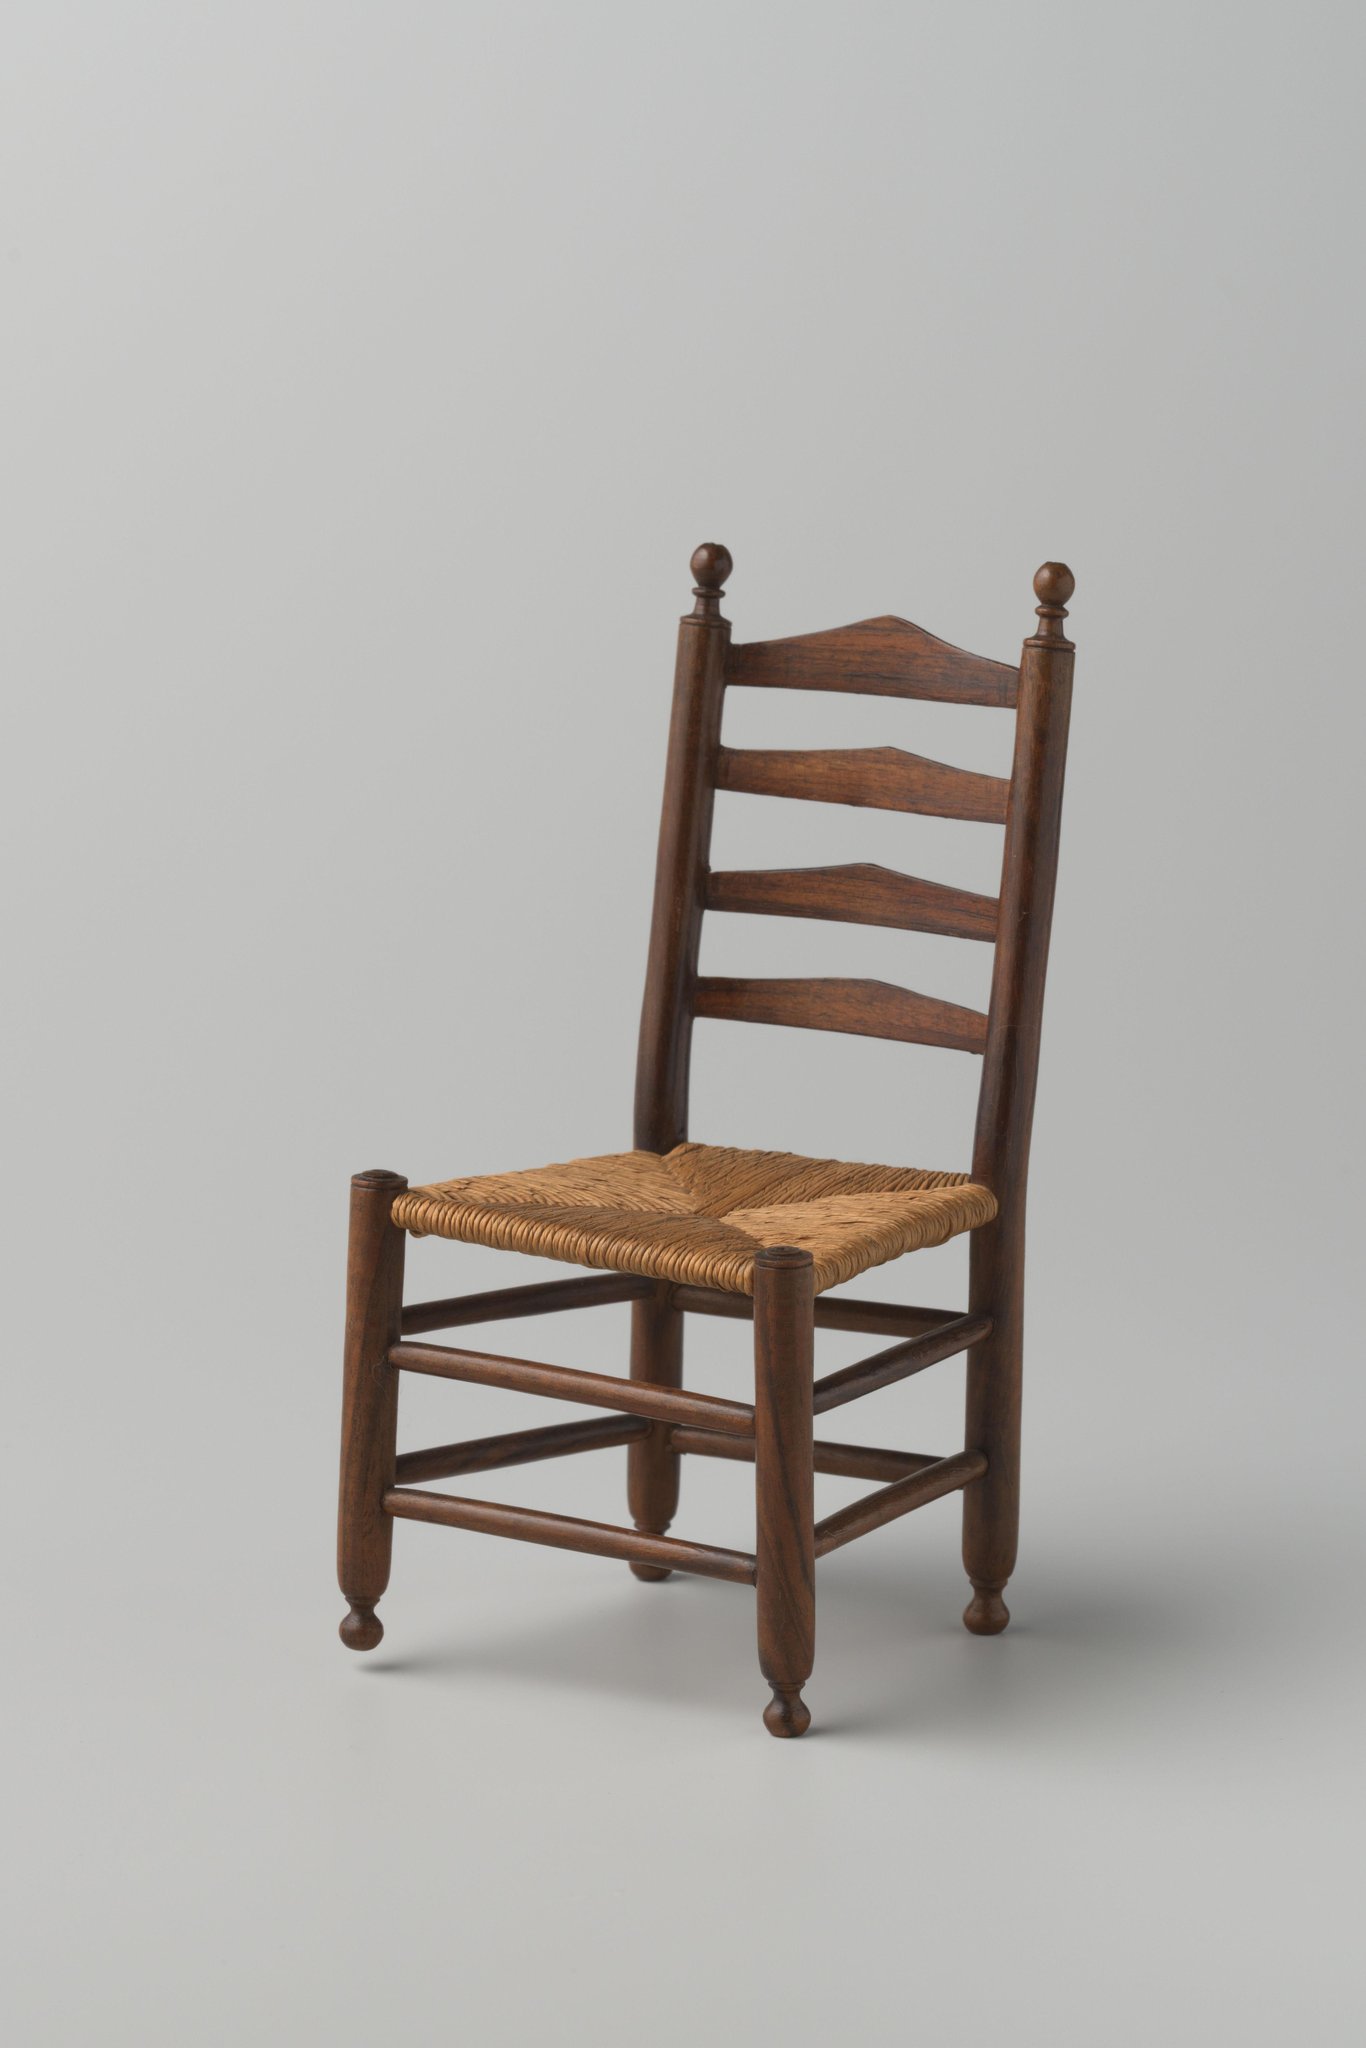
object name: miniature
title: Knopstoel met matten zitting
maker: Anonymous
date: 1690-1710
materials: fiber, wood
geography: amsterdam